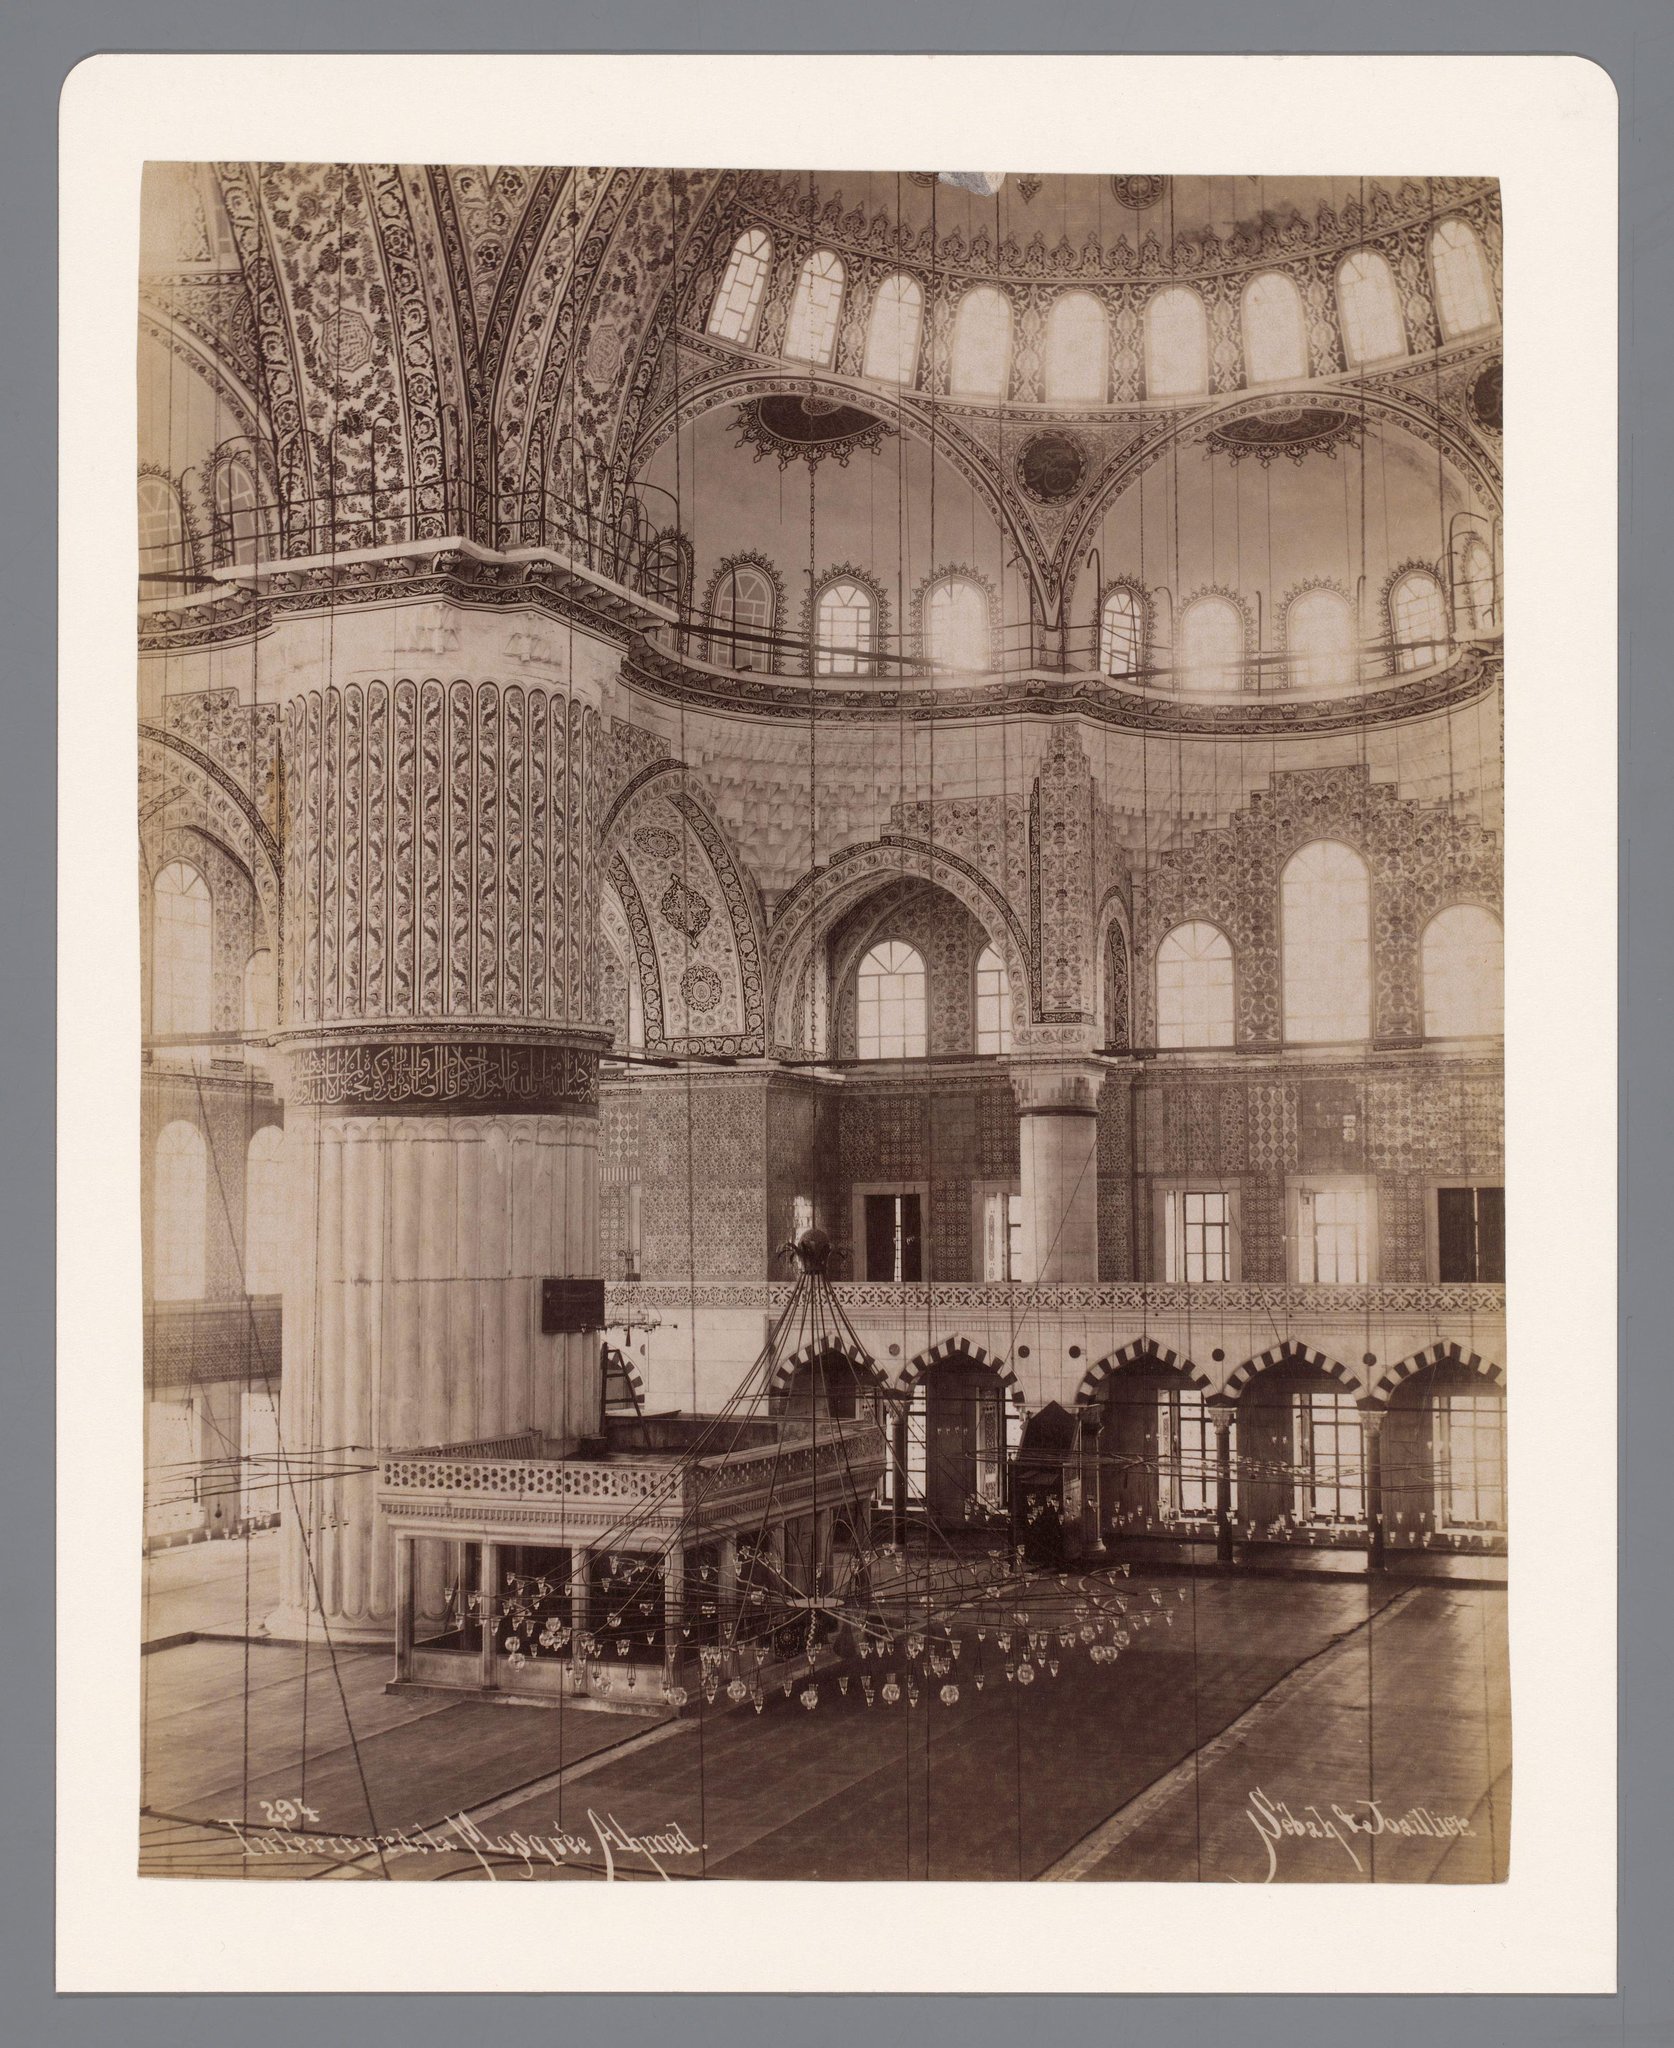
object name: photograph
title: Interieur van de Sultan Ahmetmoskee in Istanboel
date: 1888-1900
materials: paper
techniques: albumen print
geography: istanbul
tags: temple, shrine ~ islam, mohammedanism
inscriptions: number: ‘294’